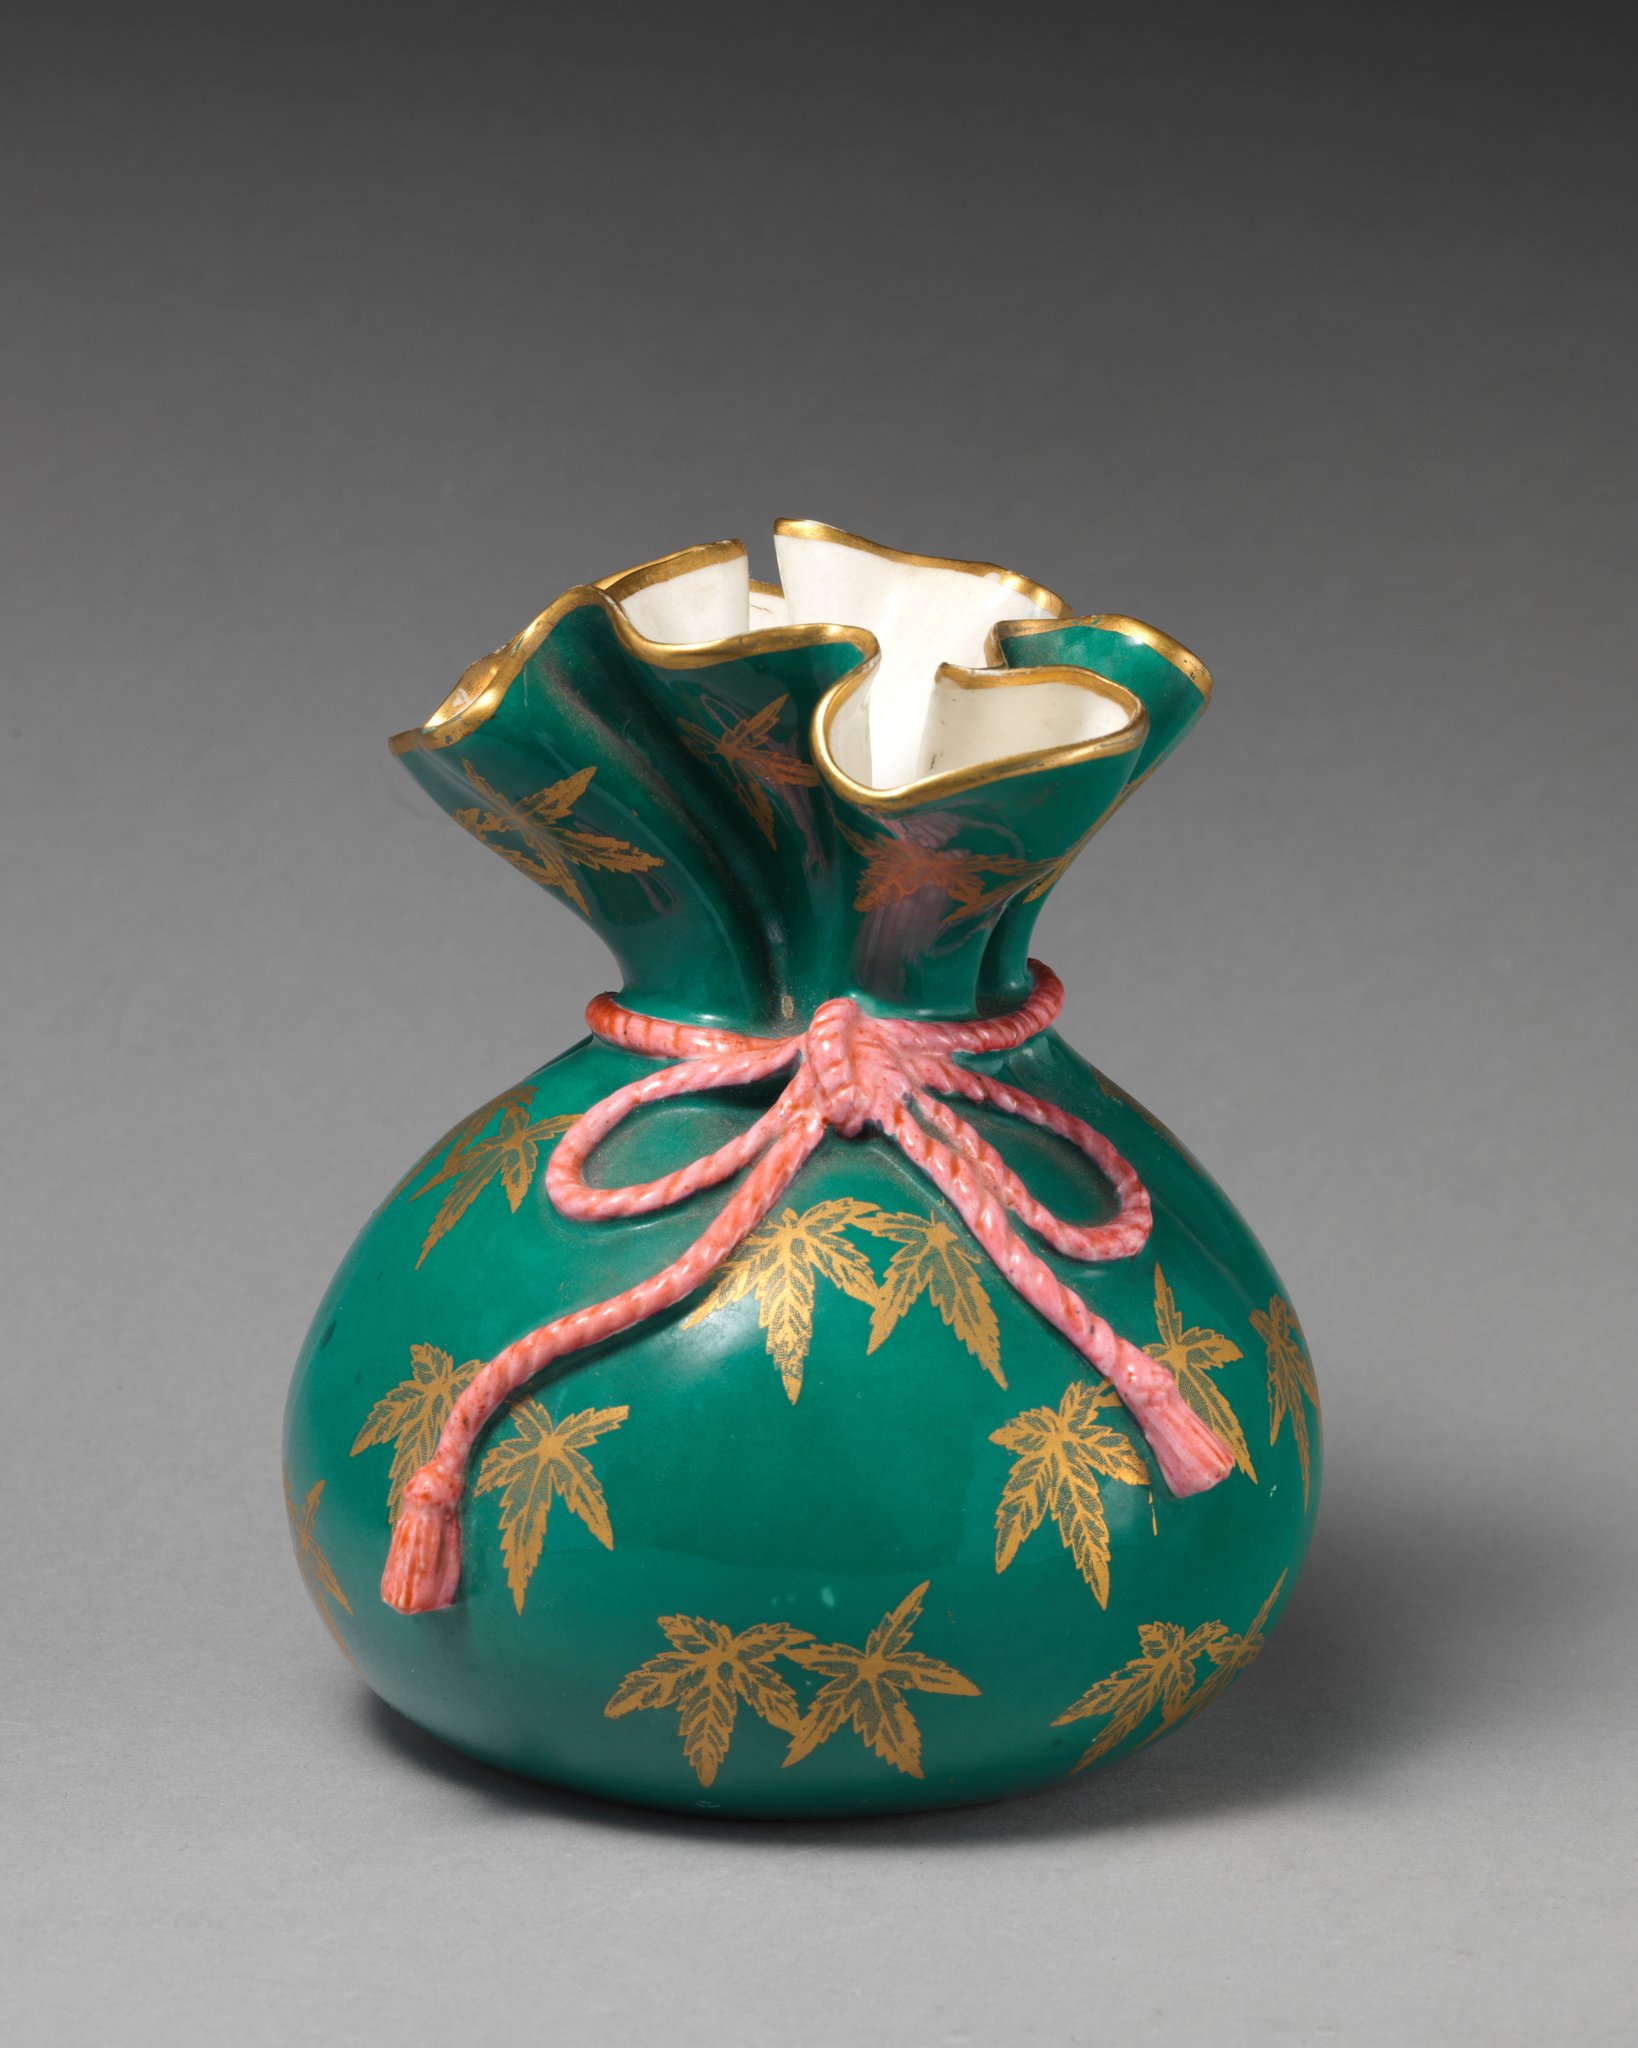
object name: vase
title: Vase in the form of a beggar's purse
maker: worcester factory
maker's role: maker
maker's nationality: british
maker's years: 1751-2008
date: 1876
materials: bone china